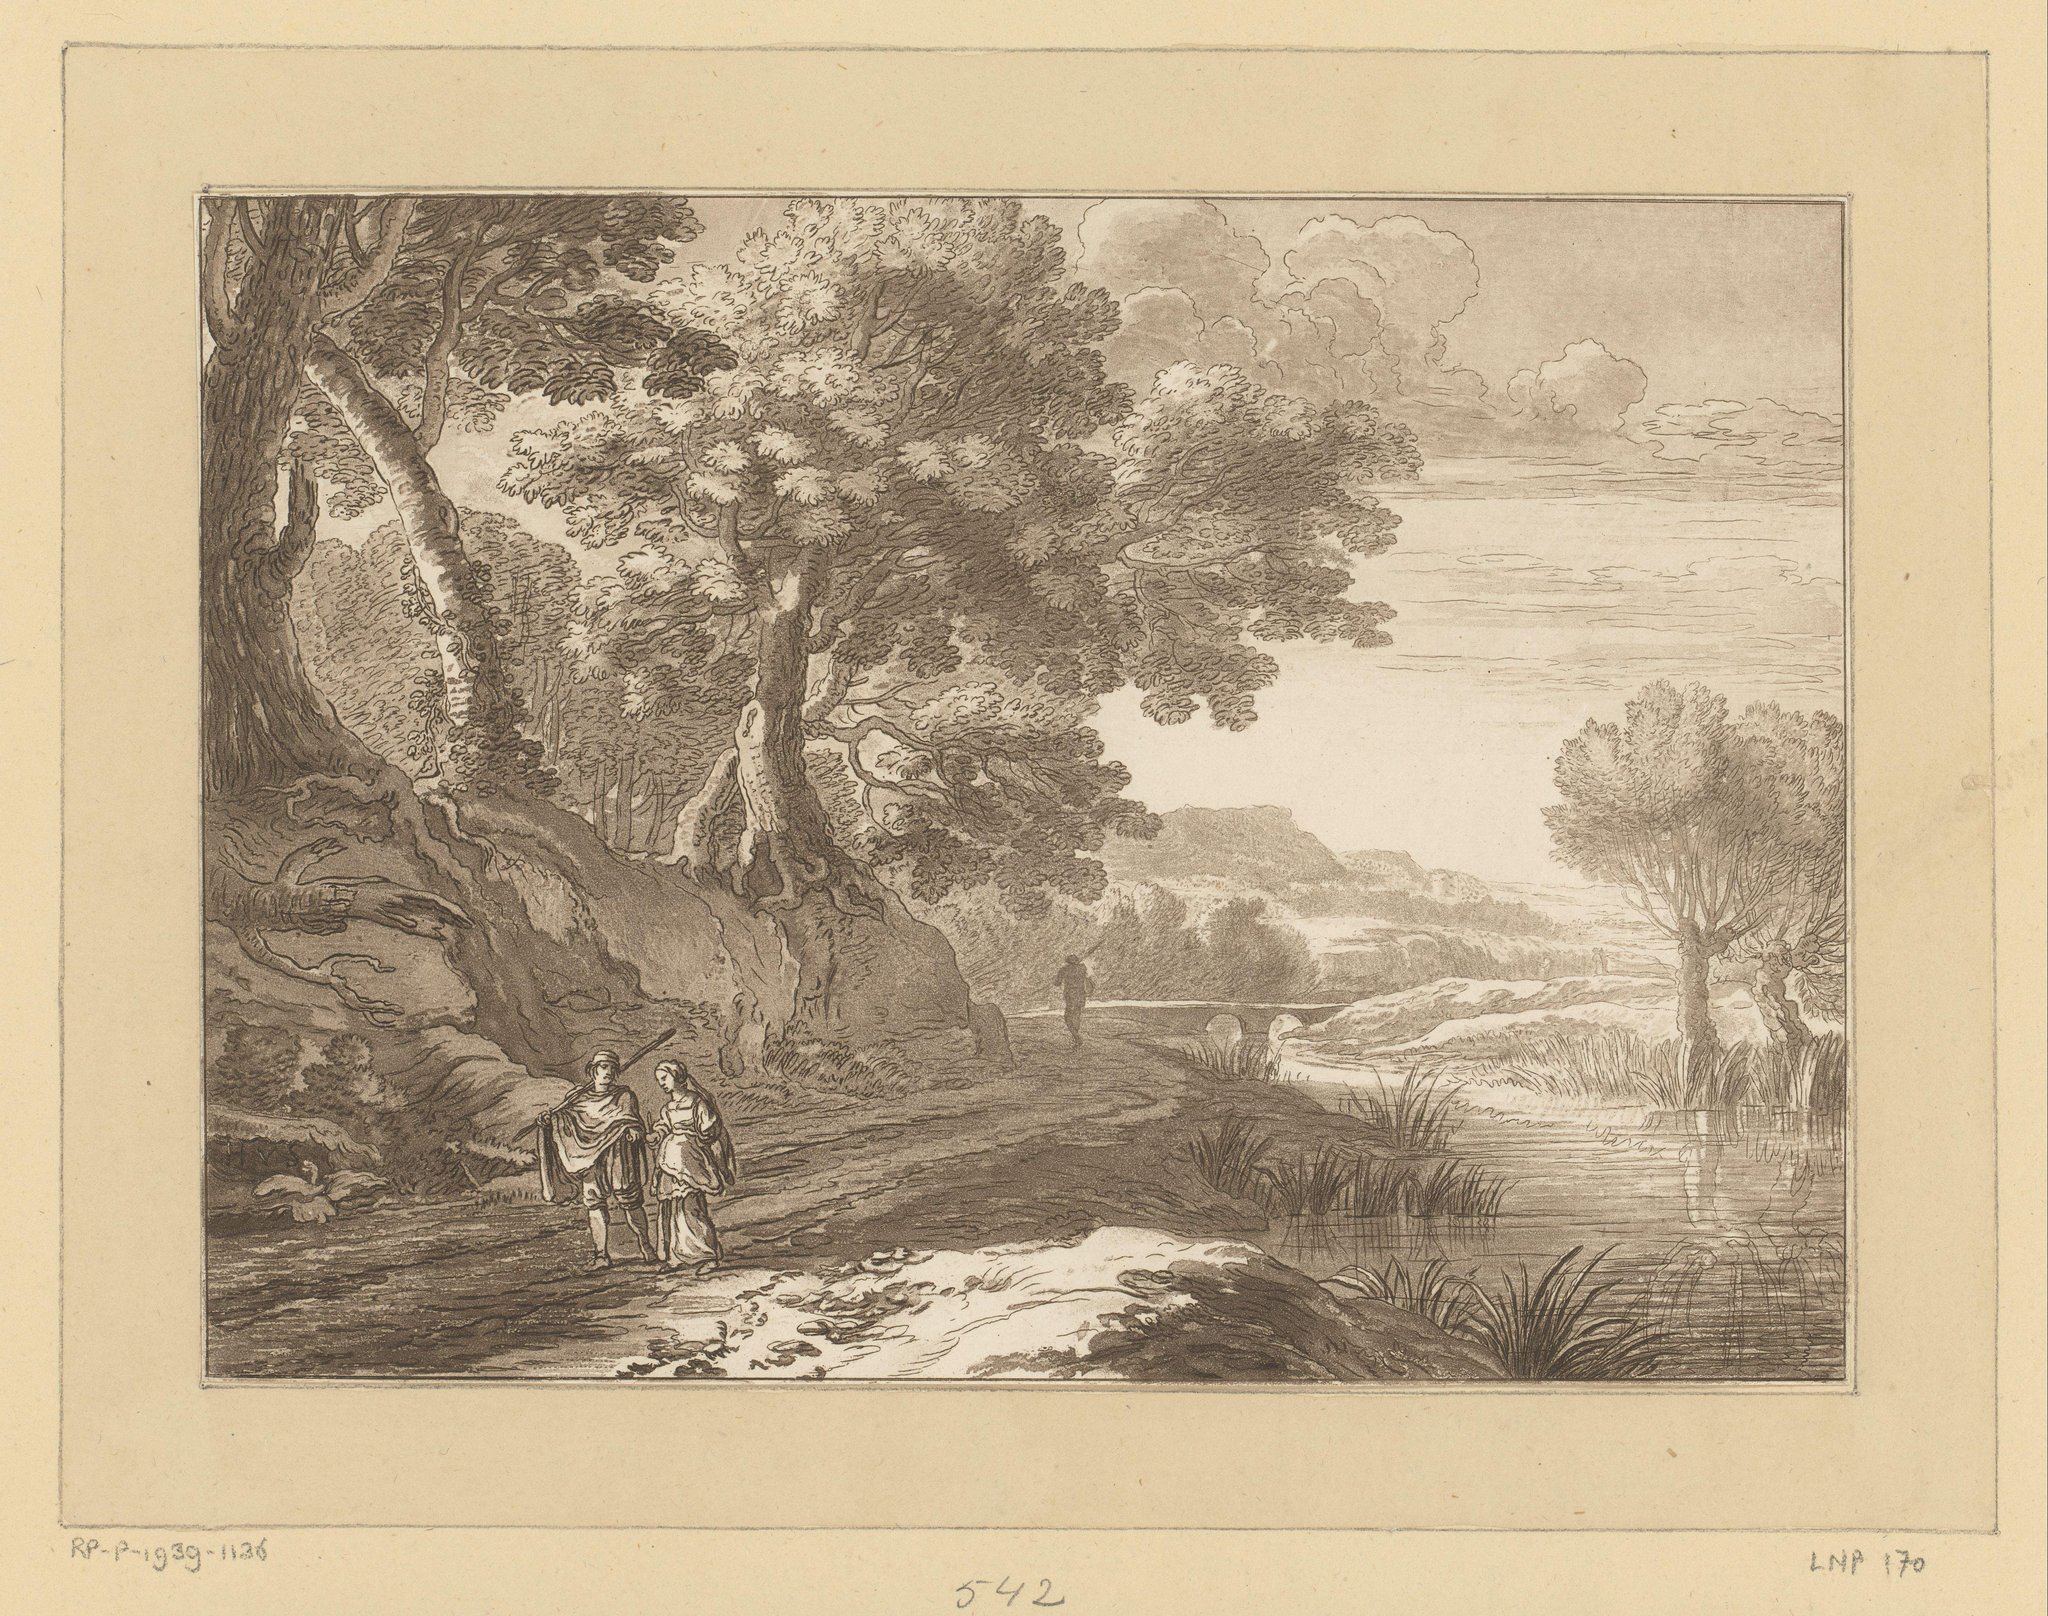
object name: print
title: Italianiserend landschap met drie wandelaars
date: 1741-1803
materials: paper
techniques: etching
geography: amsterdam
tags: river, 'en route', traveller under way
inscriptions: collector's mark: ‘RIJKS / MUSM’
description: Cornelis Brouwer heeft in samenwerking met C.S. Roos een aantal prenttekeningen uitgegeven welke op het verso het signatuur C.Brouwer fecit en C.S. Roos excudit Amst. dragen. De prent werd opgenomen in: Collection d'imitations de dessins d'après les principaux maîtres hollandais et flamands, Londen, C. Josi, 1821.